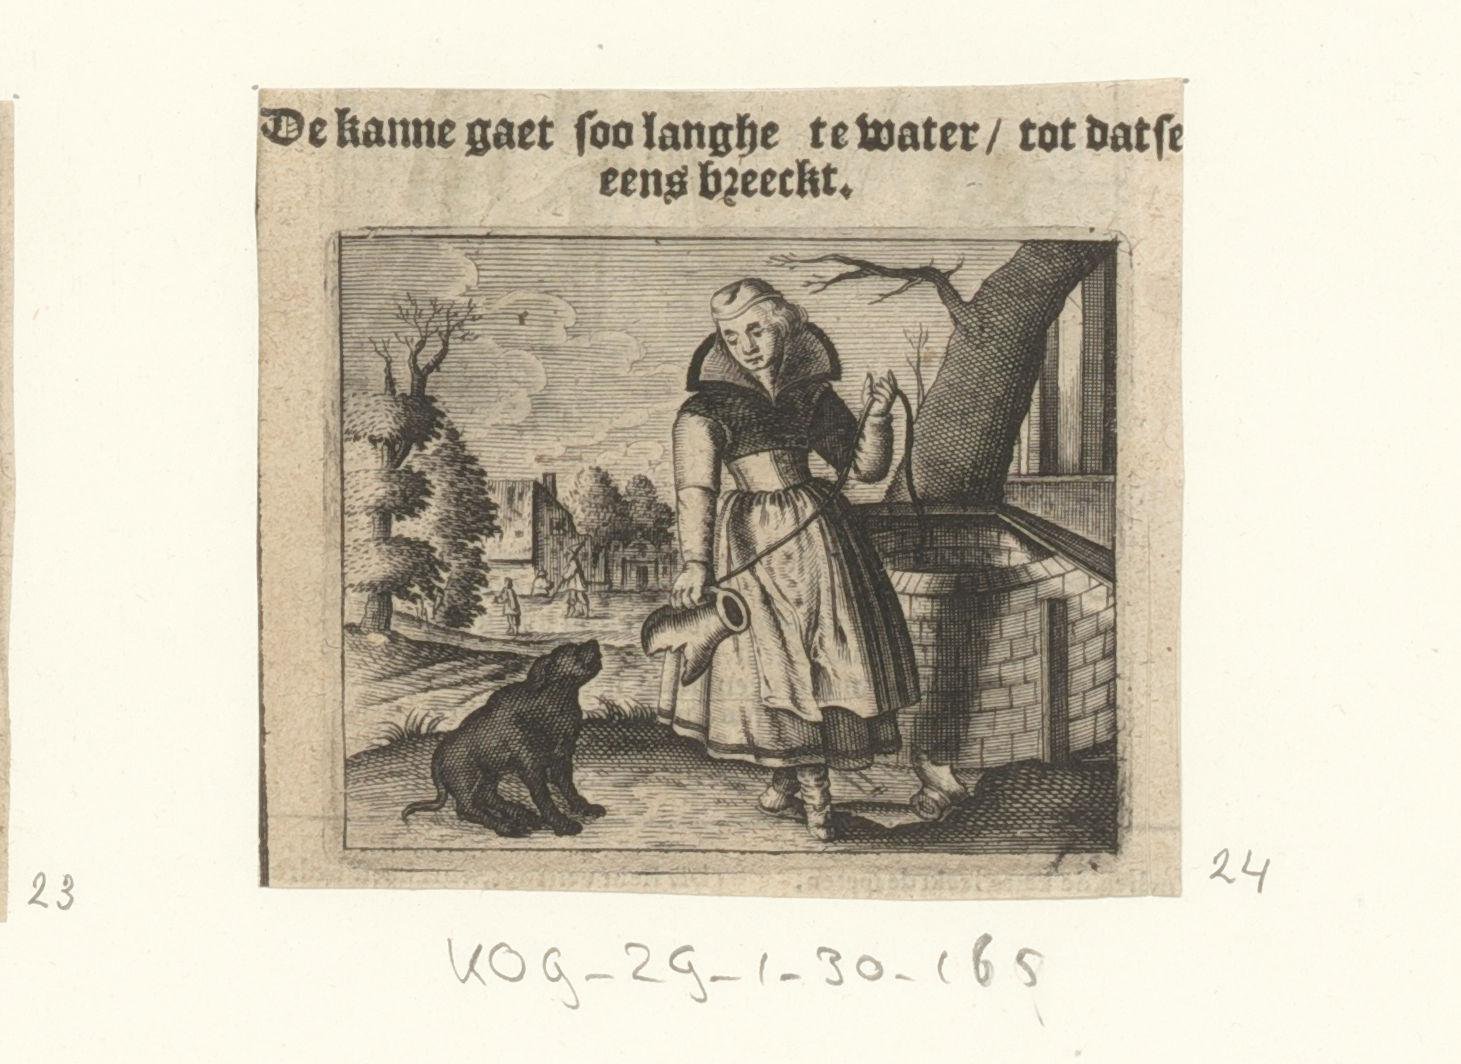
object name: print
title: Vrouw staat met een gebroken kan bij een waterput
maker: Anonymous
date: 1635-1715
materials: paper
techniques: engraving, letterpress printing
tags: well, proverbs, sayings, etc., container of ceramics: jar, jug, pot, vase, dog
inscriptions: stamp, collector's mark: Lugt 1641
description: Veel versies van dit embleem verschenen in verschillende uitgave van Spiegel van den Ouden ende Nieuwen Tydt. Zoals: Cats, Jacob. Spiegel van den Ouden ende Nieuwen-tijt, Bestaende uyt Spreeck-woorden (...). Dordrecht: Jacob Braat, 1647. Maar ook in andere publicaties (1665, 1671, 1715, 1722).